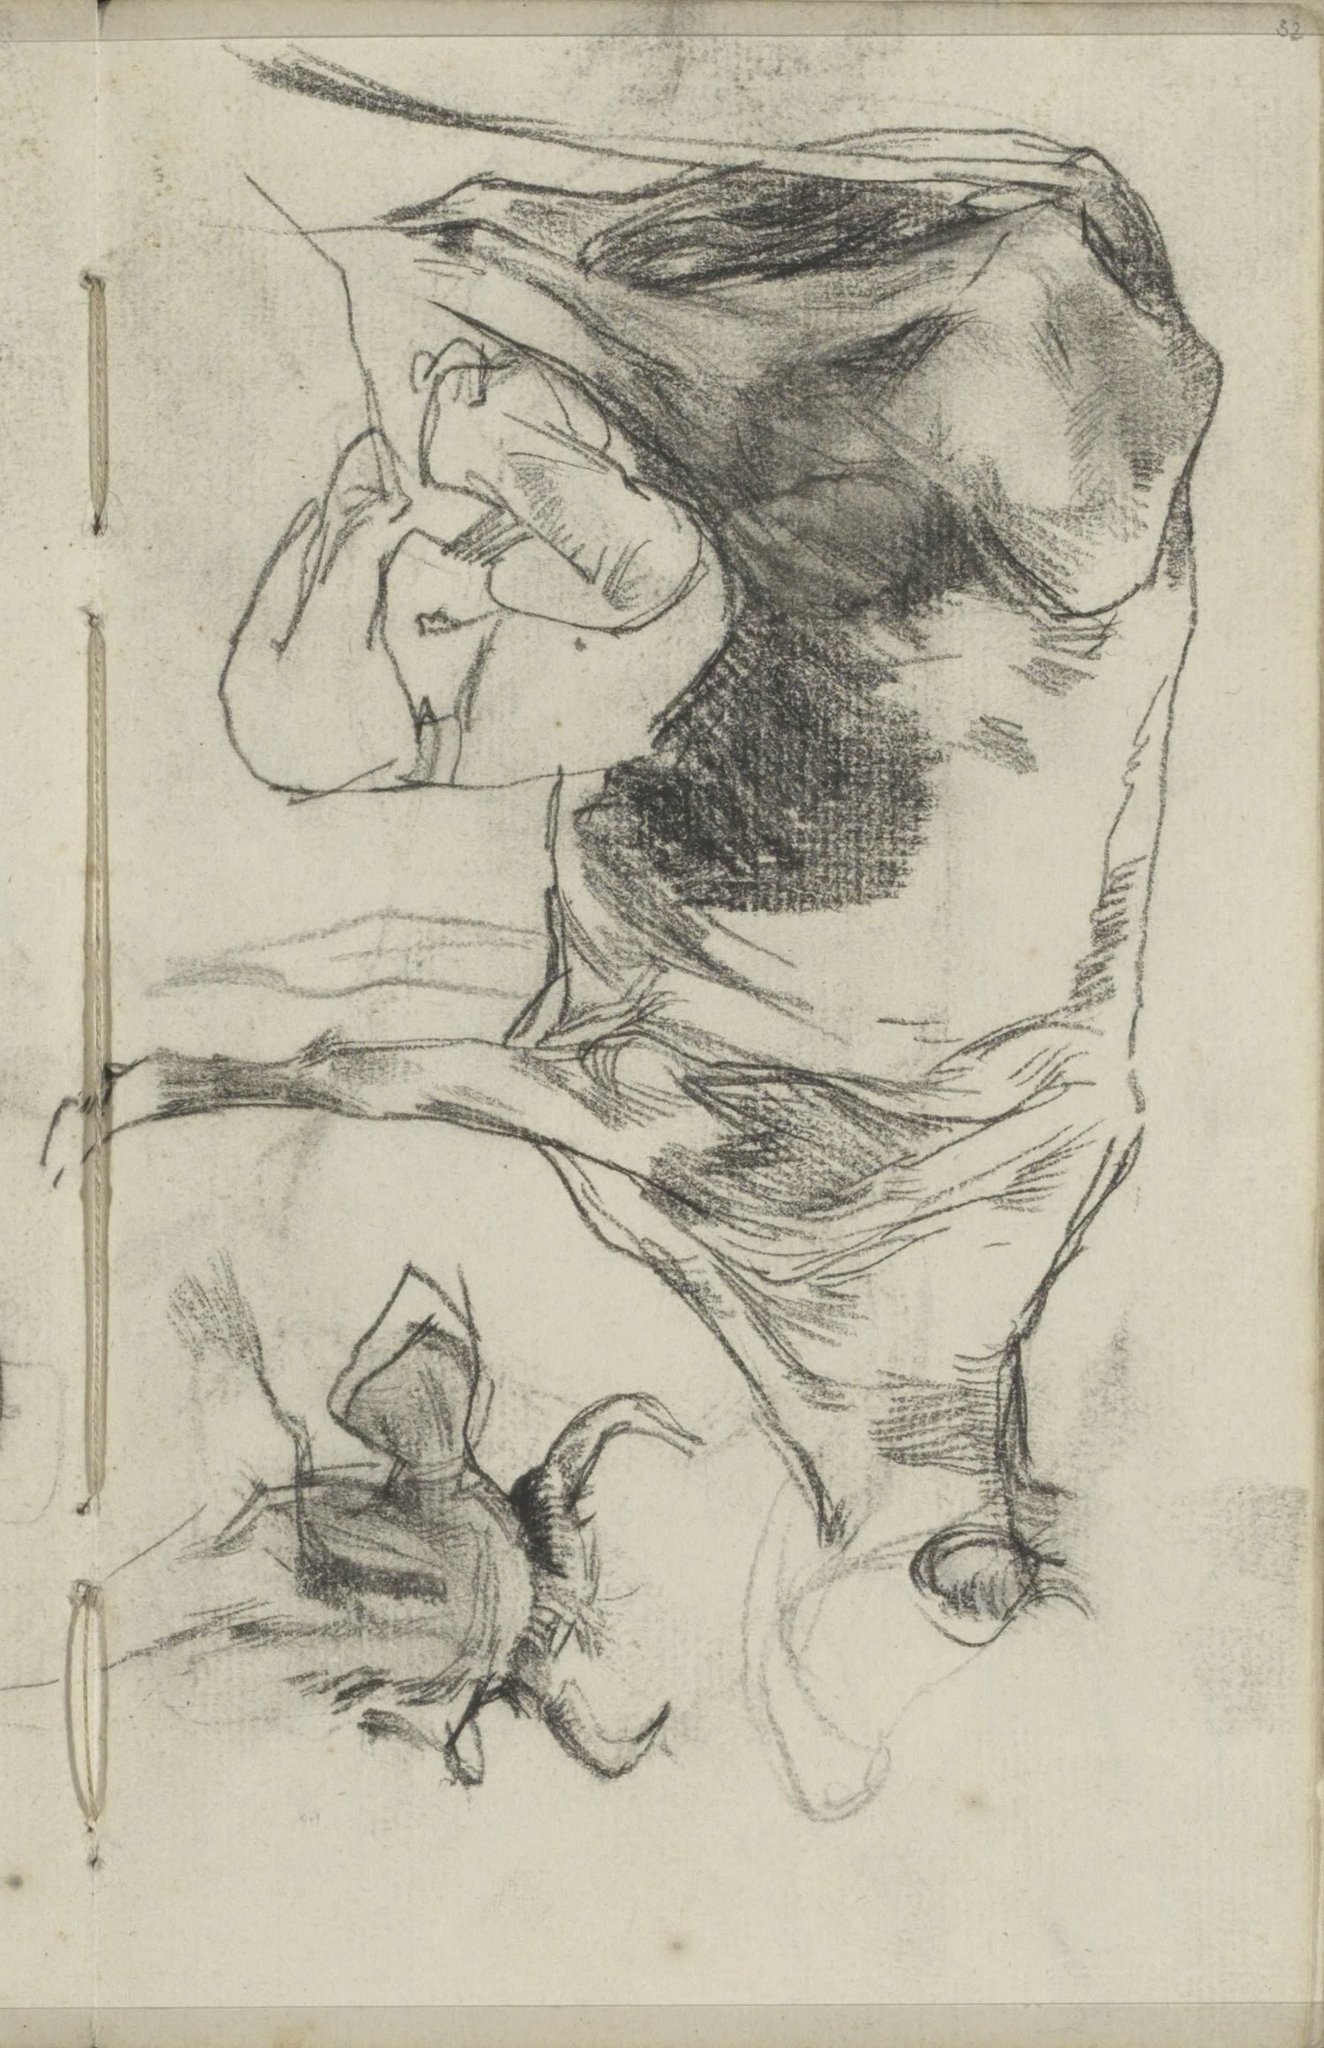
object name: sketchbook leaf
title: Melkende boer en een koeienkop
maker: george hendrik breitner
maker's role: draughtsman, painter, print maker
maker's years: 1857-1923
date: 1887-1889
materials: chalk, paper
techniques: stumping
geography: the hague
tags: cow, milking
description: Pagina 32 uit een schetsboek met 27 bladen.